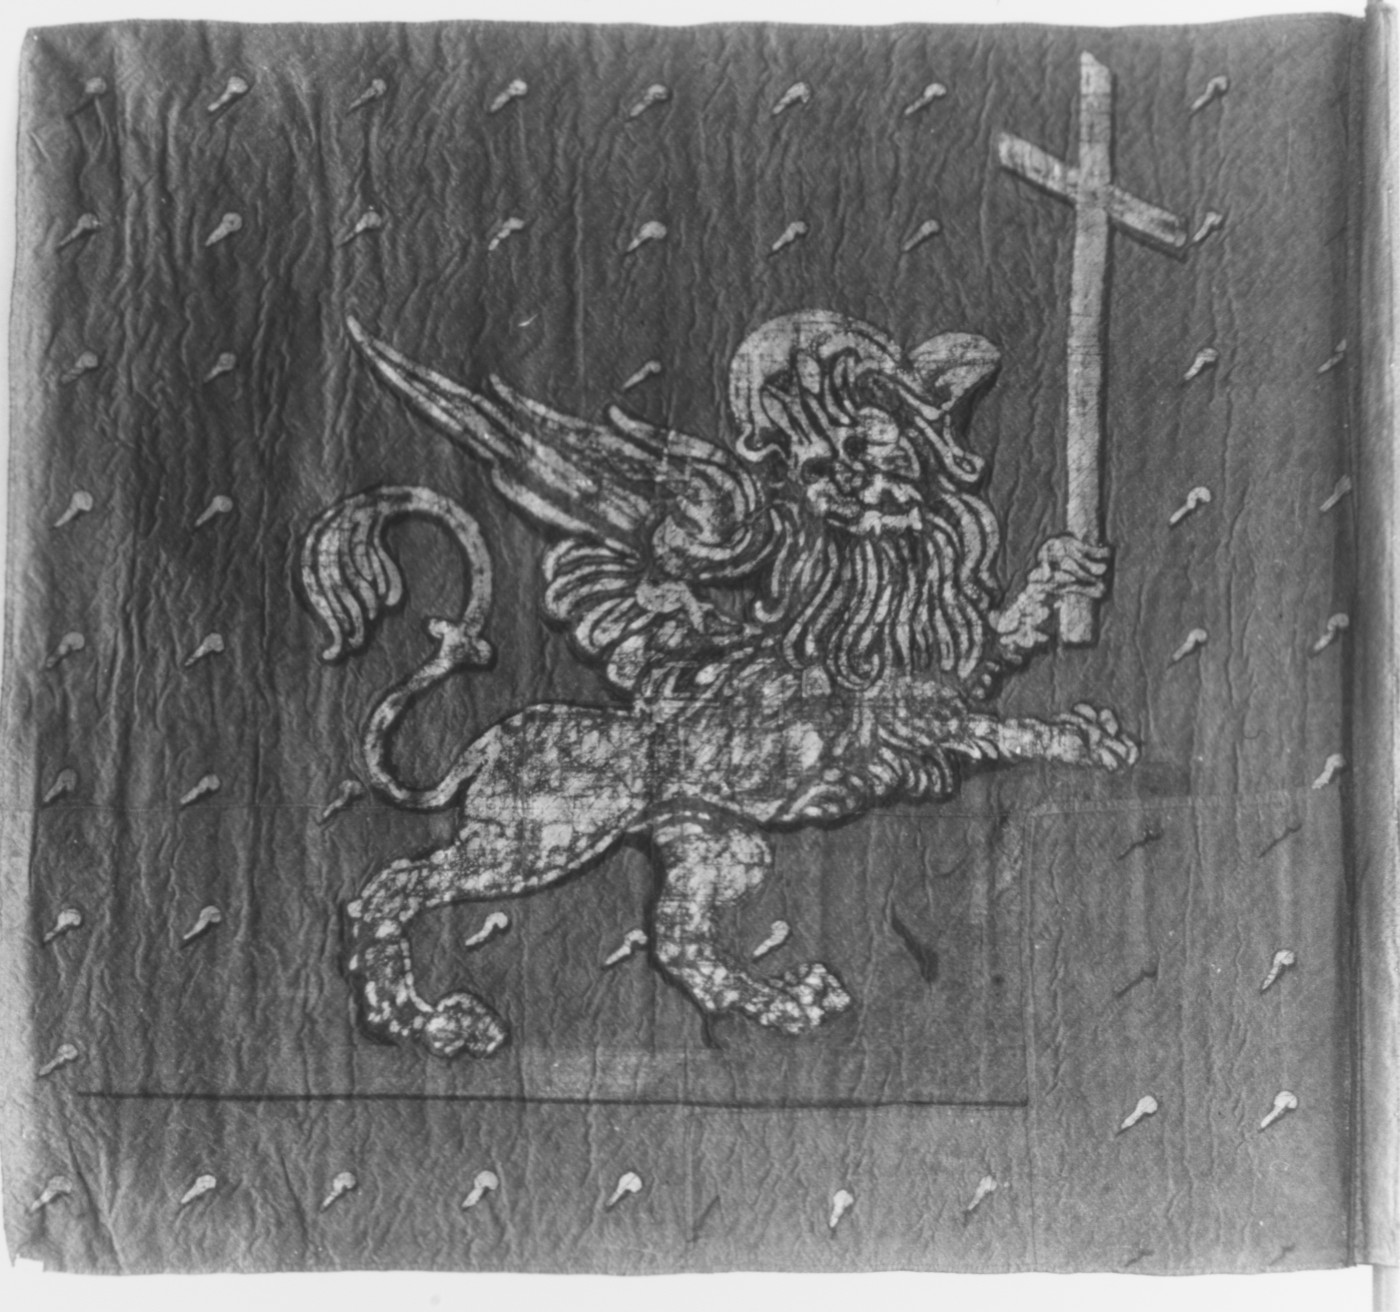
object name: banner with shaft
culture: italian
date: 1701-1800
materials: paint, silk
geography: italy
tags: lions